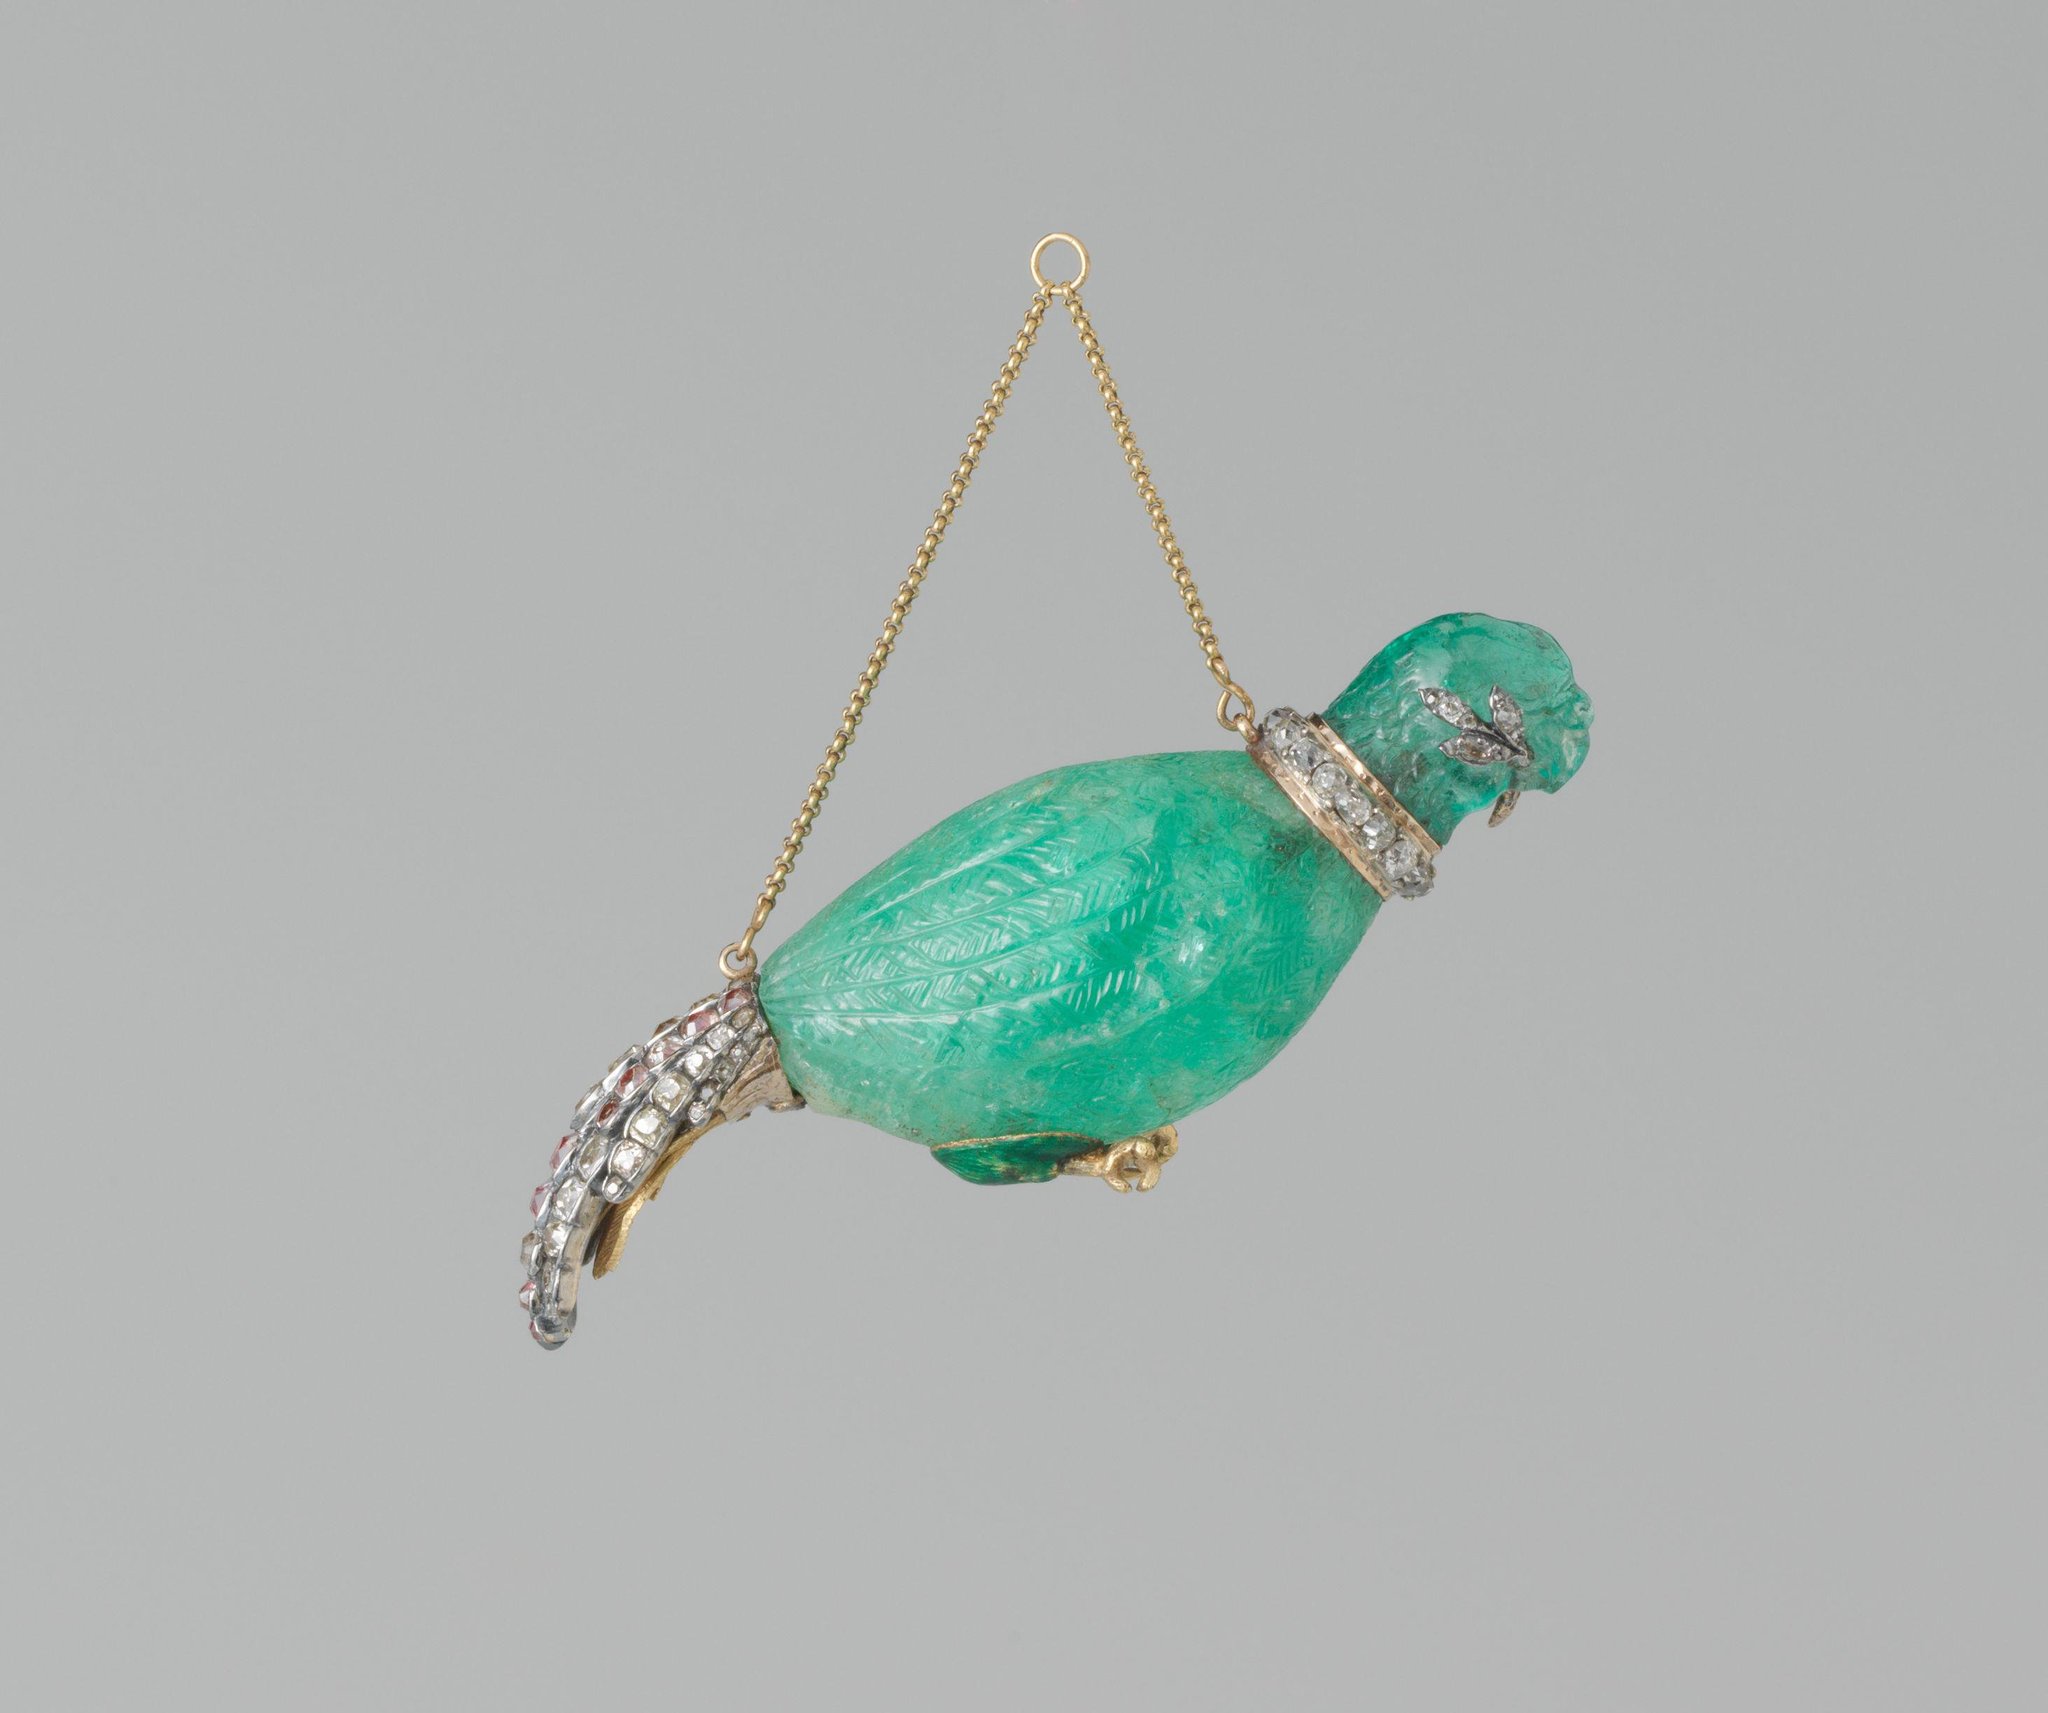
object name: pendant jewelry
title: Hanger in de vorm van een papegaai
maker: Anonymous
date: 1680-1700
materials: diamond, gemstone, gold, silver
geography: portugal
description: Pendant. Silver, emerald and diamonds. Portugal or Spain, c. 1680-1700.